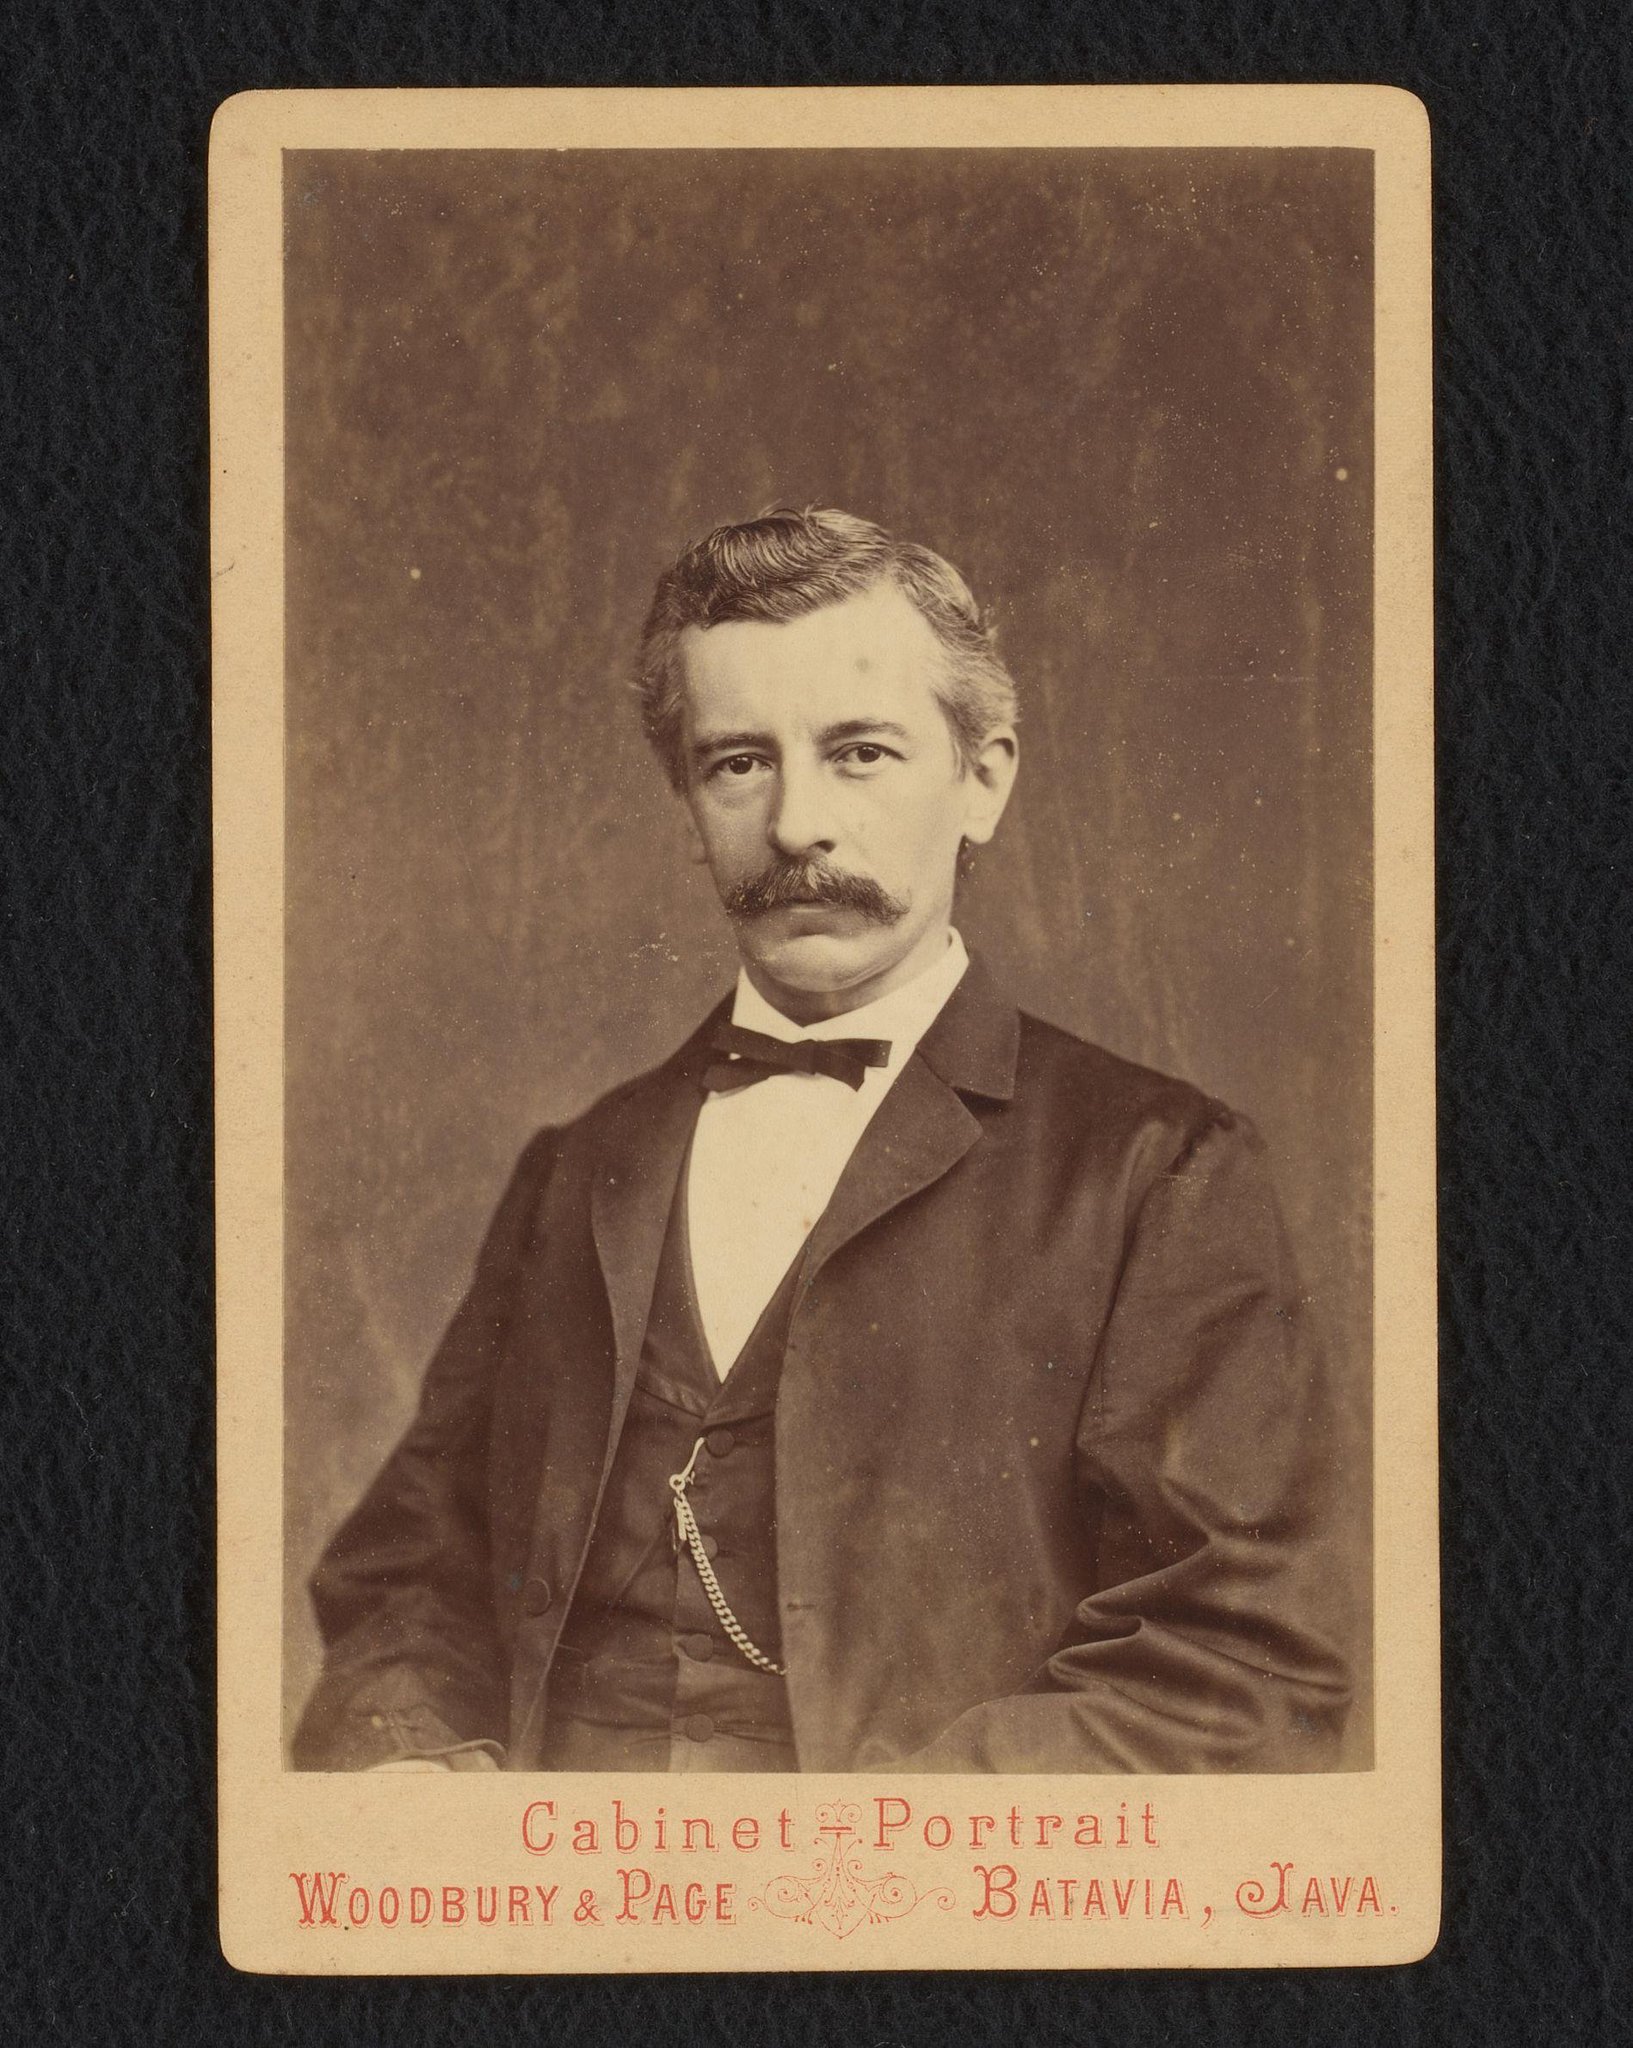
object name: cabinet photograph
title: Portret van vermoedelijk H.J. Kessler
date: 1879-1885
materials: cardboard, paper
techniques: albumen print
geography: java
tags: hermanus johannes kessler (1820-1895), historical persons